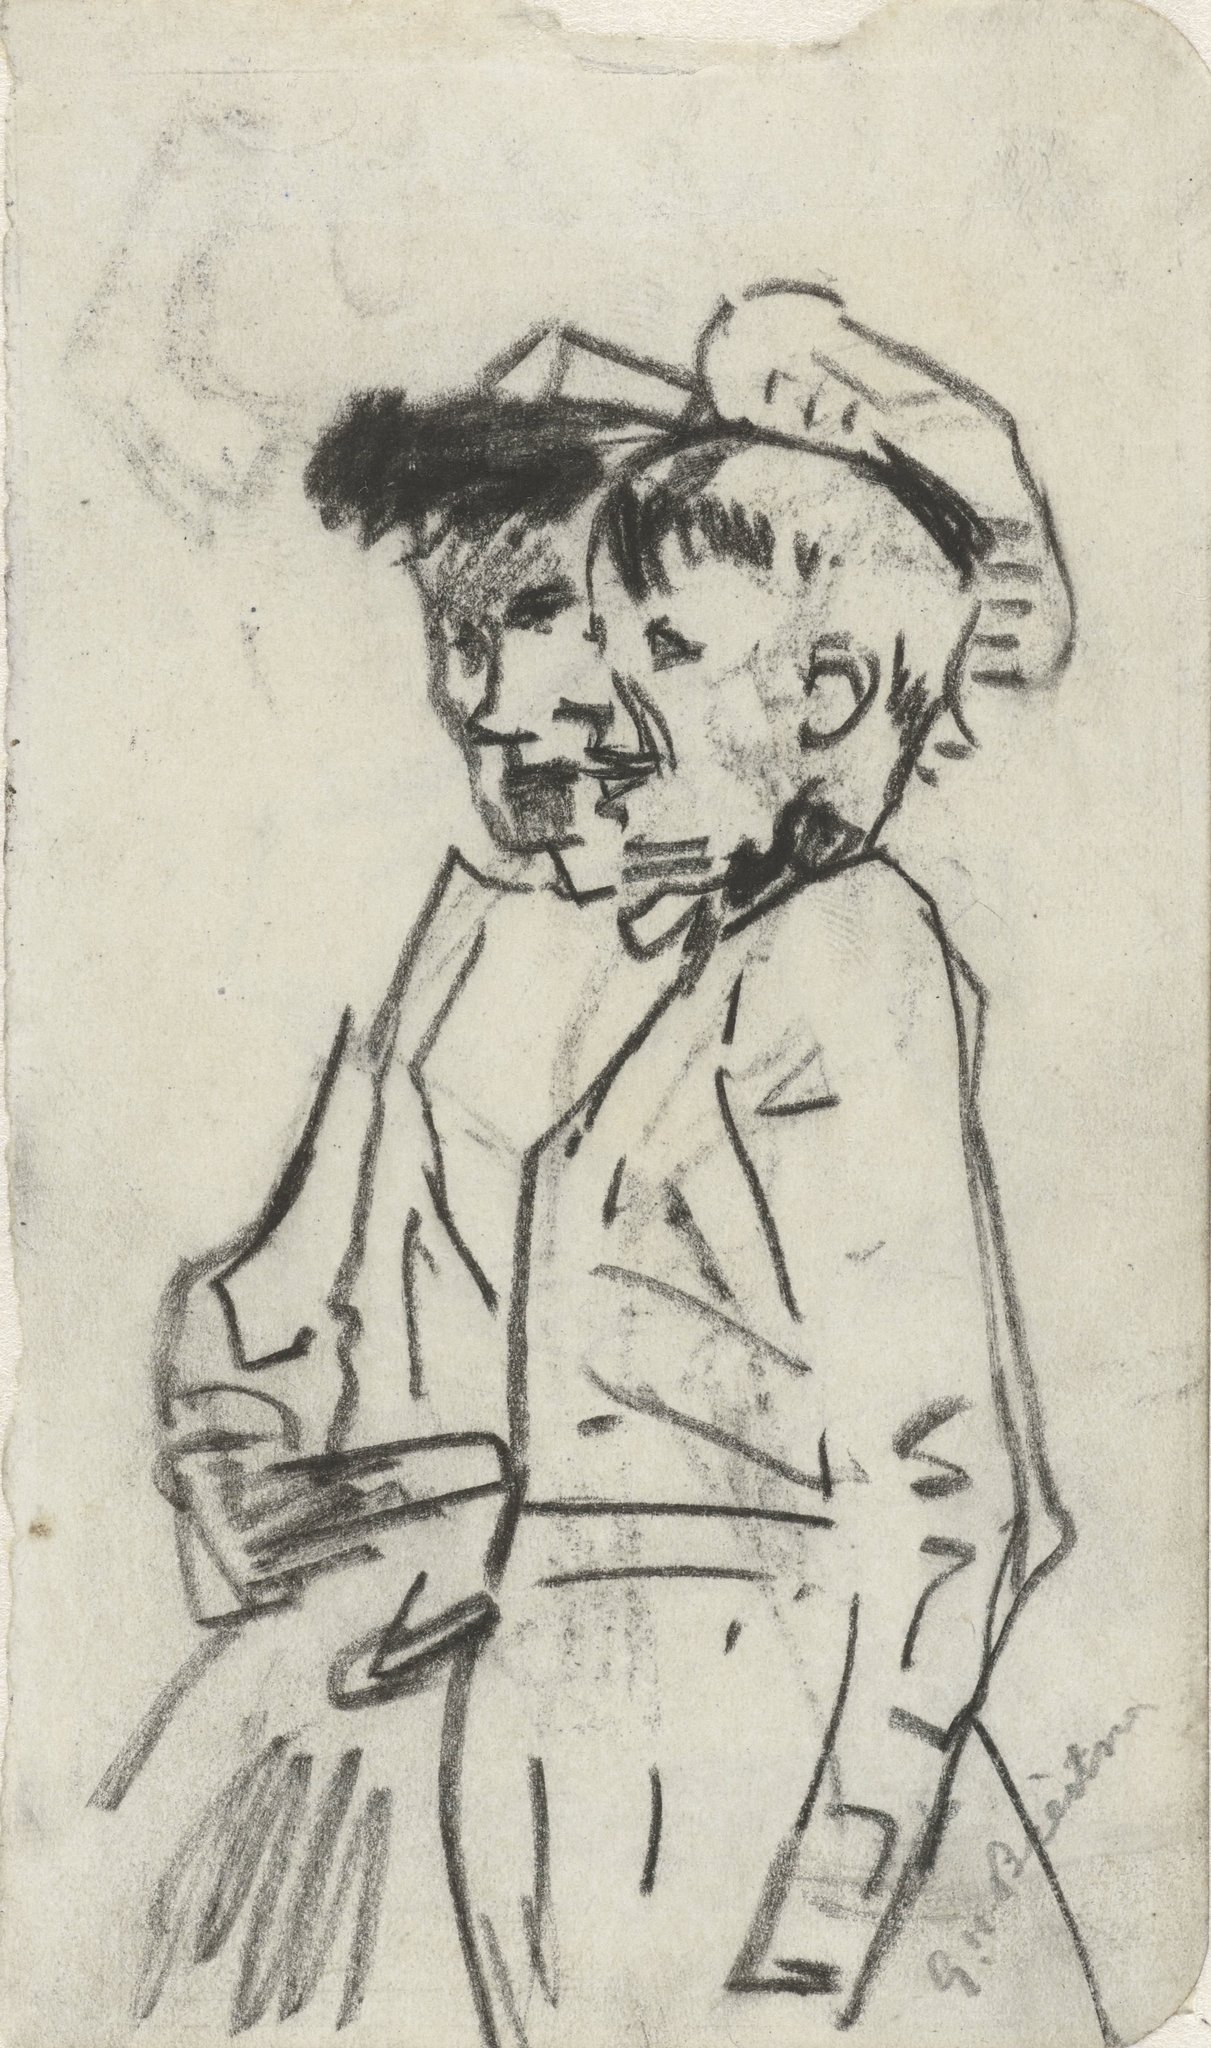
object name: drawing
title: Twee dienstmeisjes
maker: george hendrik breitner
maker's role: draughtsman, painter, print maker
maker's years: 1857-1923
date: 1867-1923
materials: chalk, paper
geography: amsterdam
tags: maid ~ house personnel